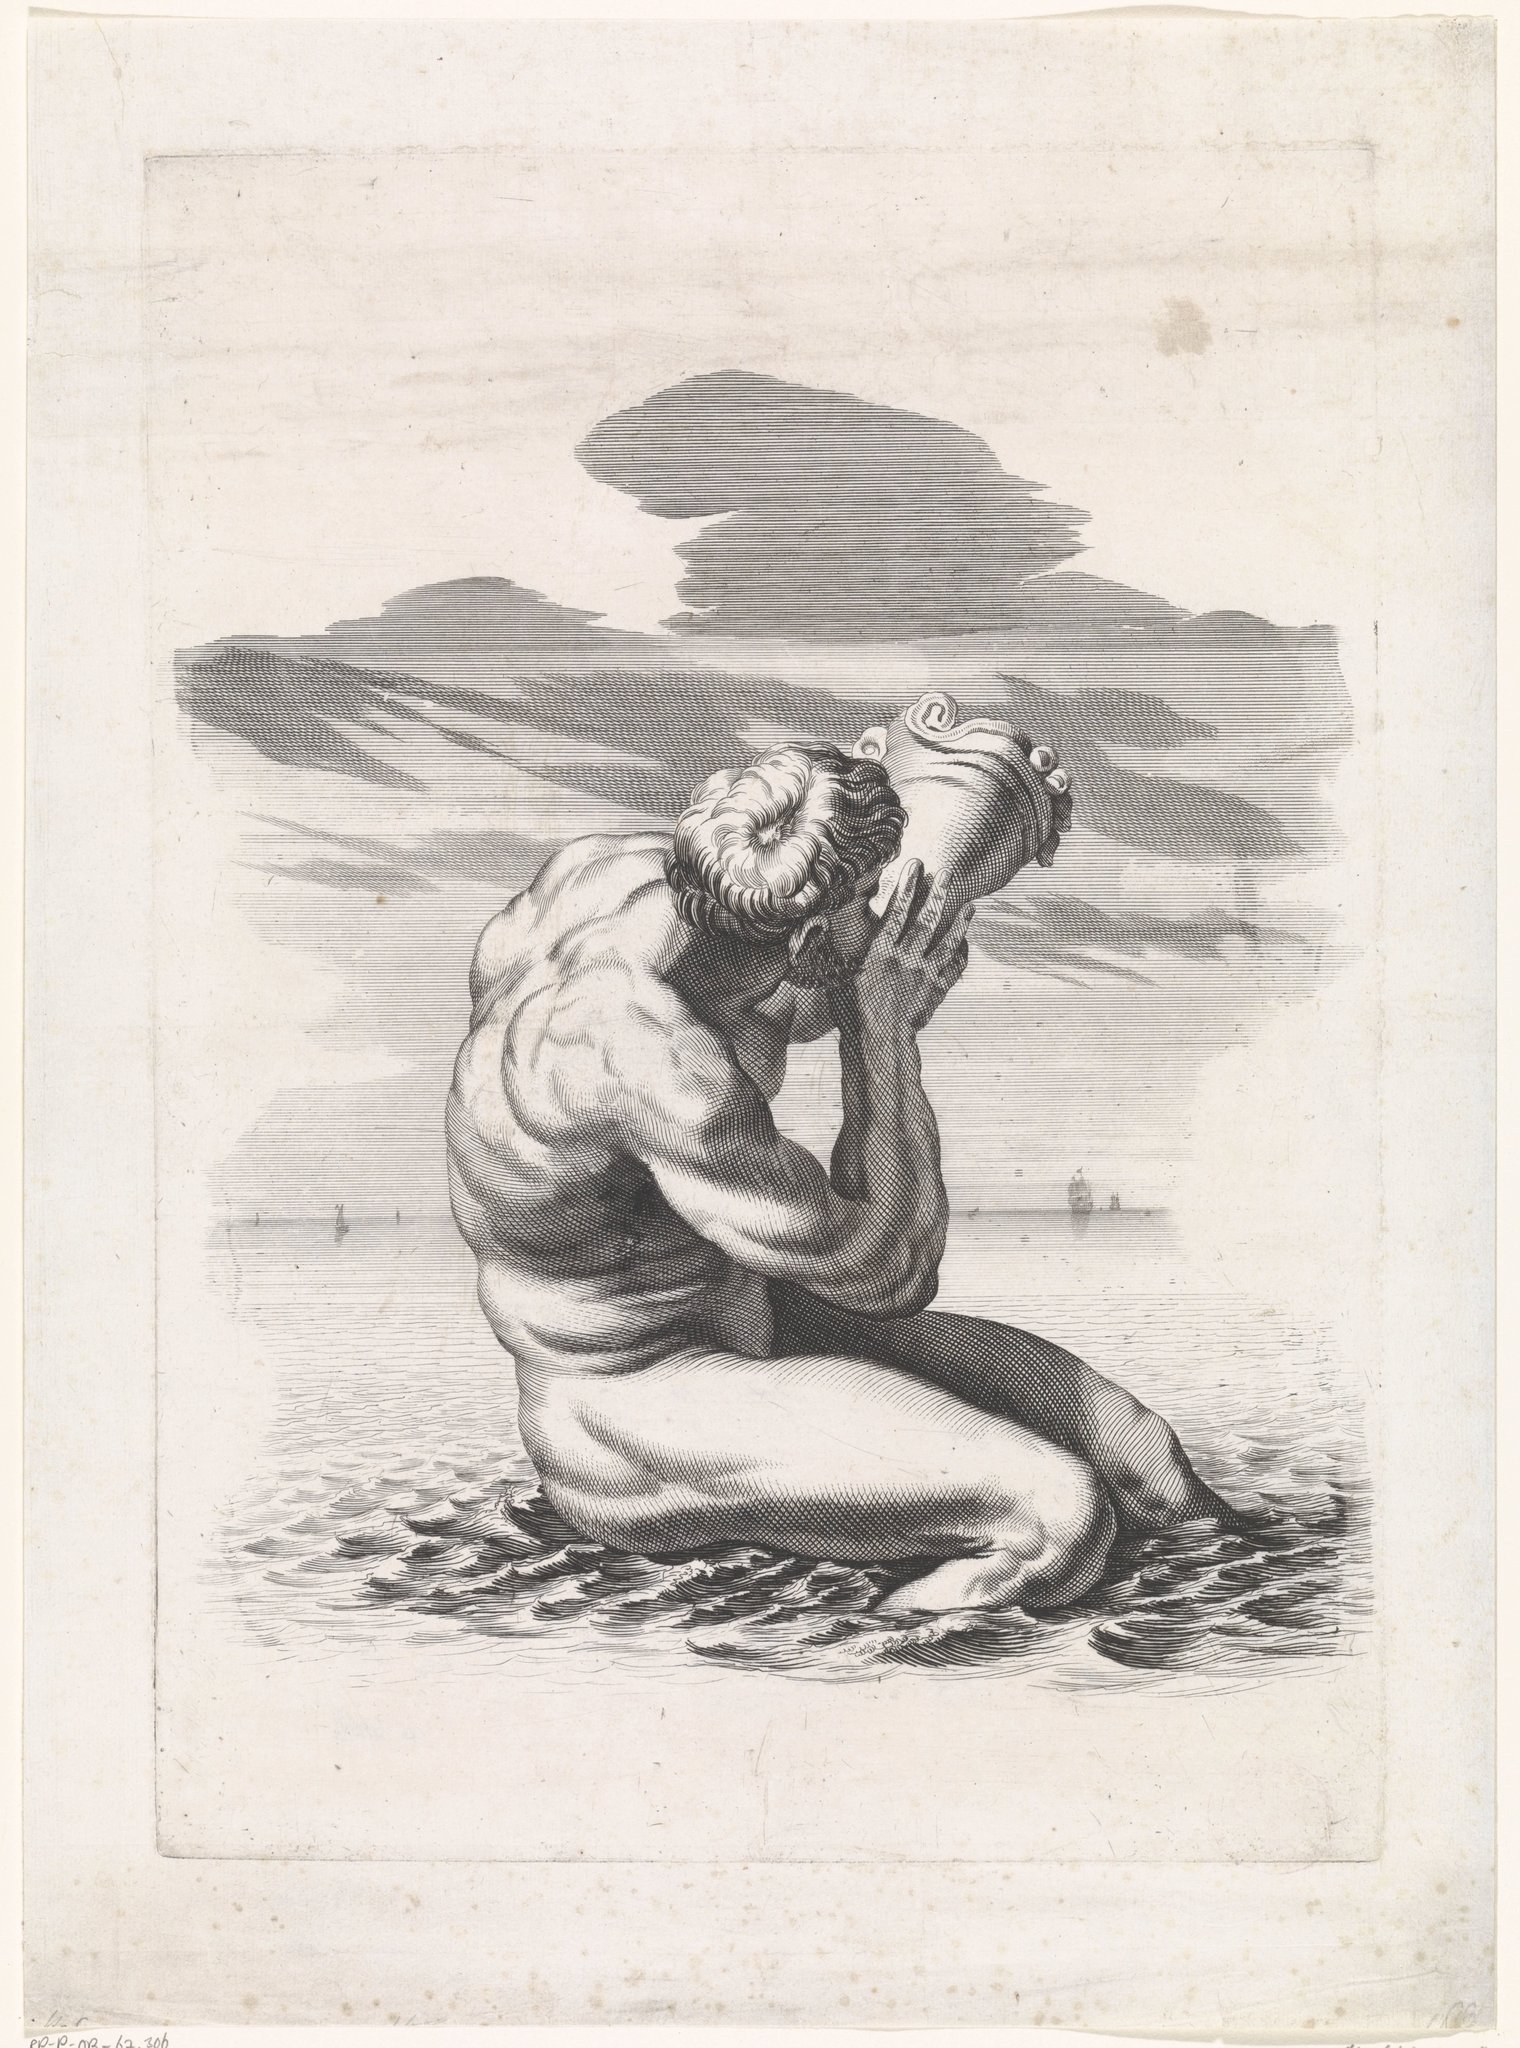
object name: print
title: Triton blaast op zijn schelp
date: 1688-1750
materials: paper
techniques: engraving, etching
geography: netherlands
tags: triton(s)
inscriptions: collector's mark: Lugt 240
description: Een triton blaast op zijn tritonhoorn of schelp. Op de achtergrond schepen op zee.